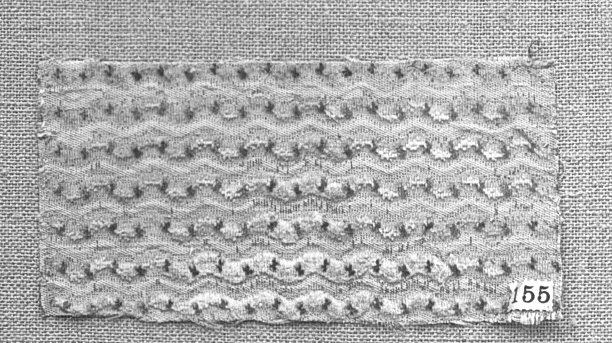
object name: piece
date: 1701-1800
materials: metal thread, silk